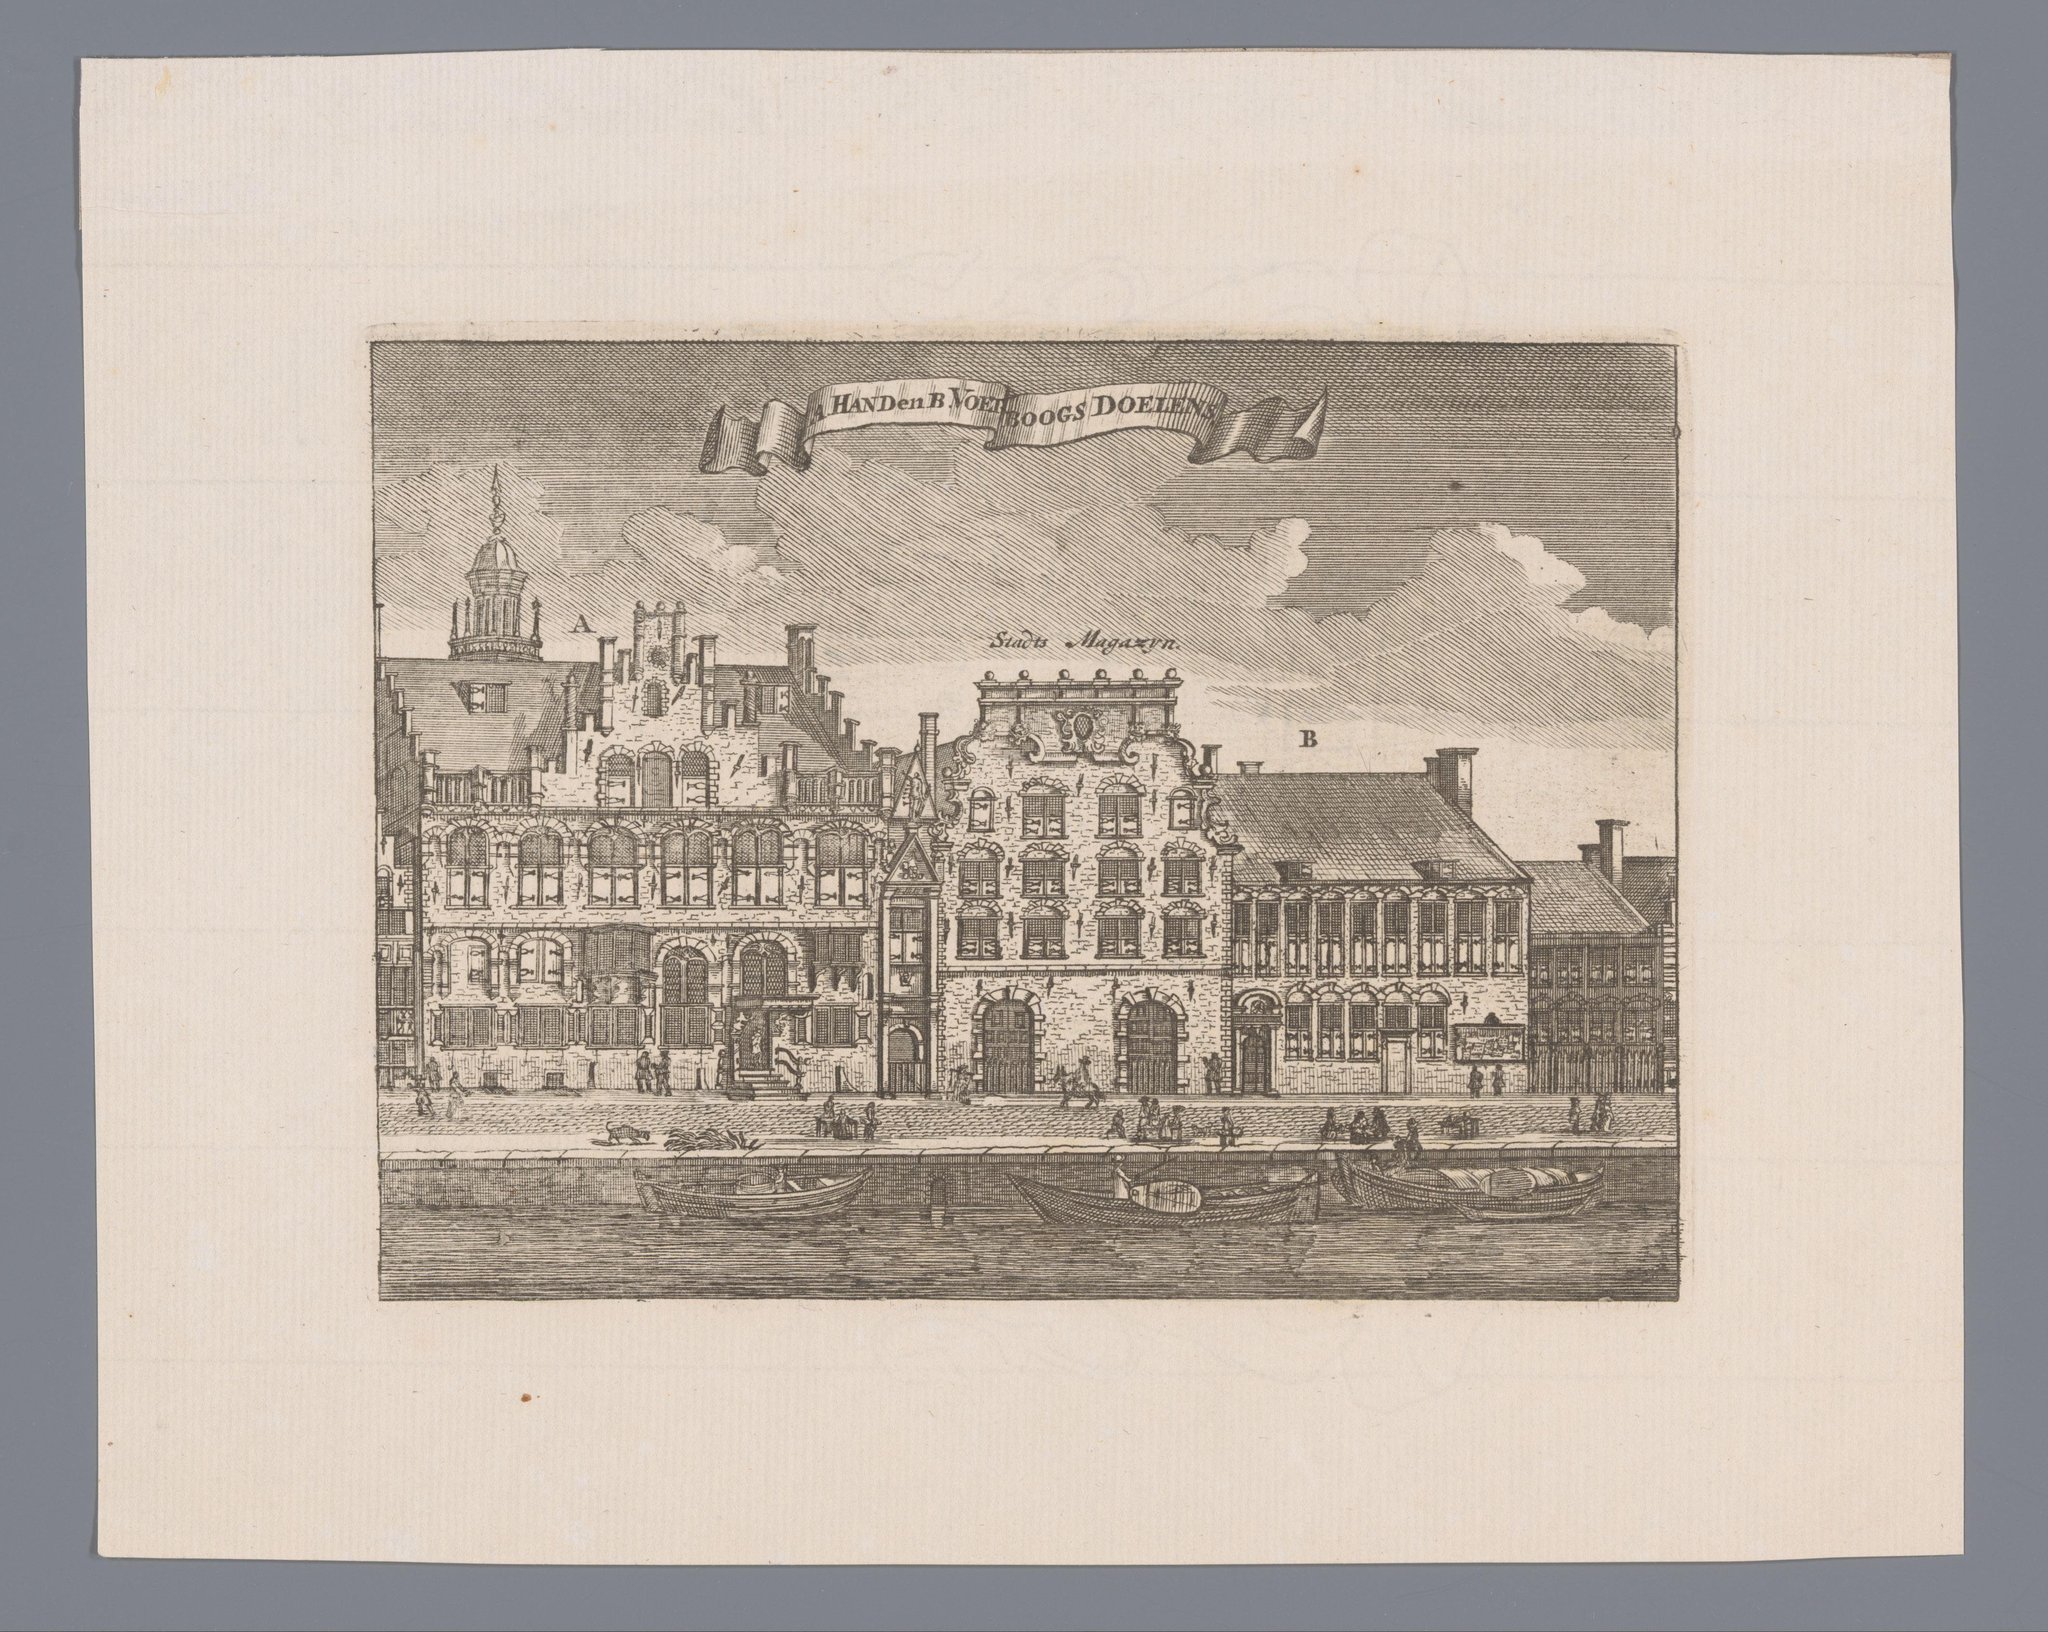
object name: print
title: A. Hand en B. Voetboogs Doelens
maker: Anonymous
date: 1693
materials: paper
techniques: etching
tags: civic architecture; edifices; dwellings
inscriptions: watermark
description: Eerdere staat van deze prent is verschenen in: Commelin, Caspar. Beschryvinge van Amsterdam, desselfs eerste oorspronk uyt den Huyse der Heeren van Aemstel en Aemstellant (...). dl. 2. Amsterdam: Wolfgang, Waasberge, Boom, Van Someren en Goethals, 1693.